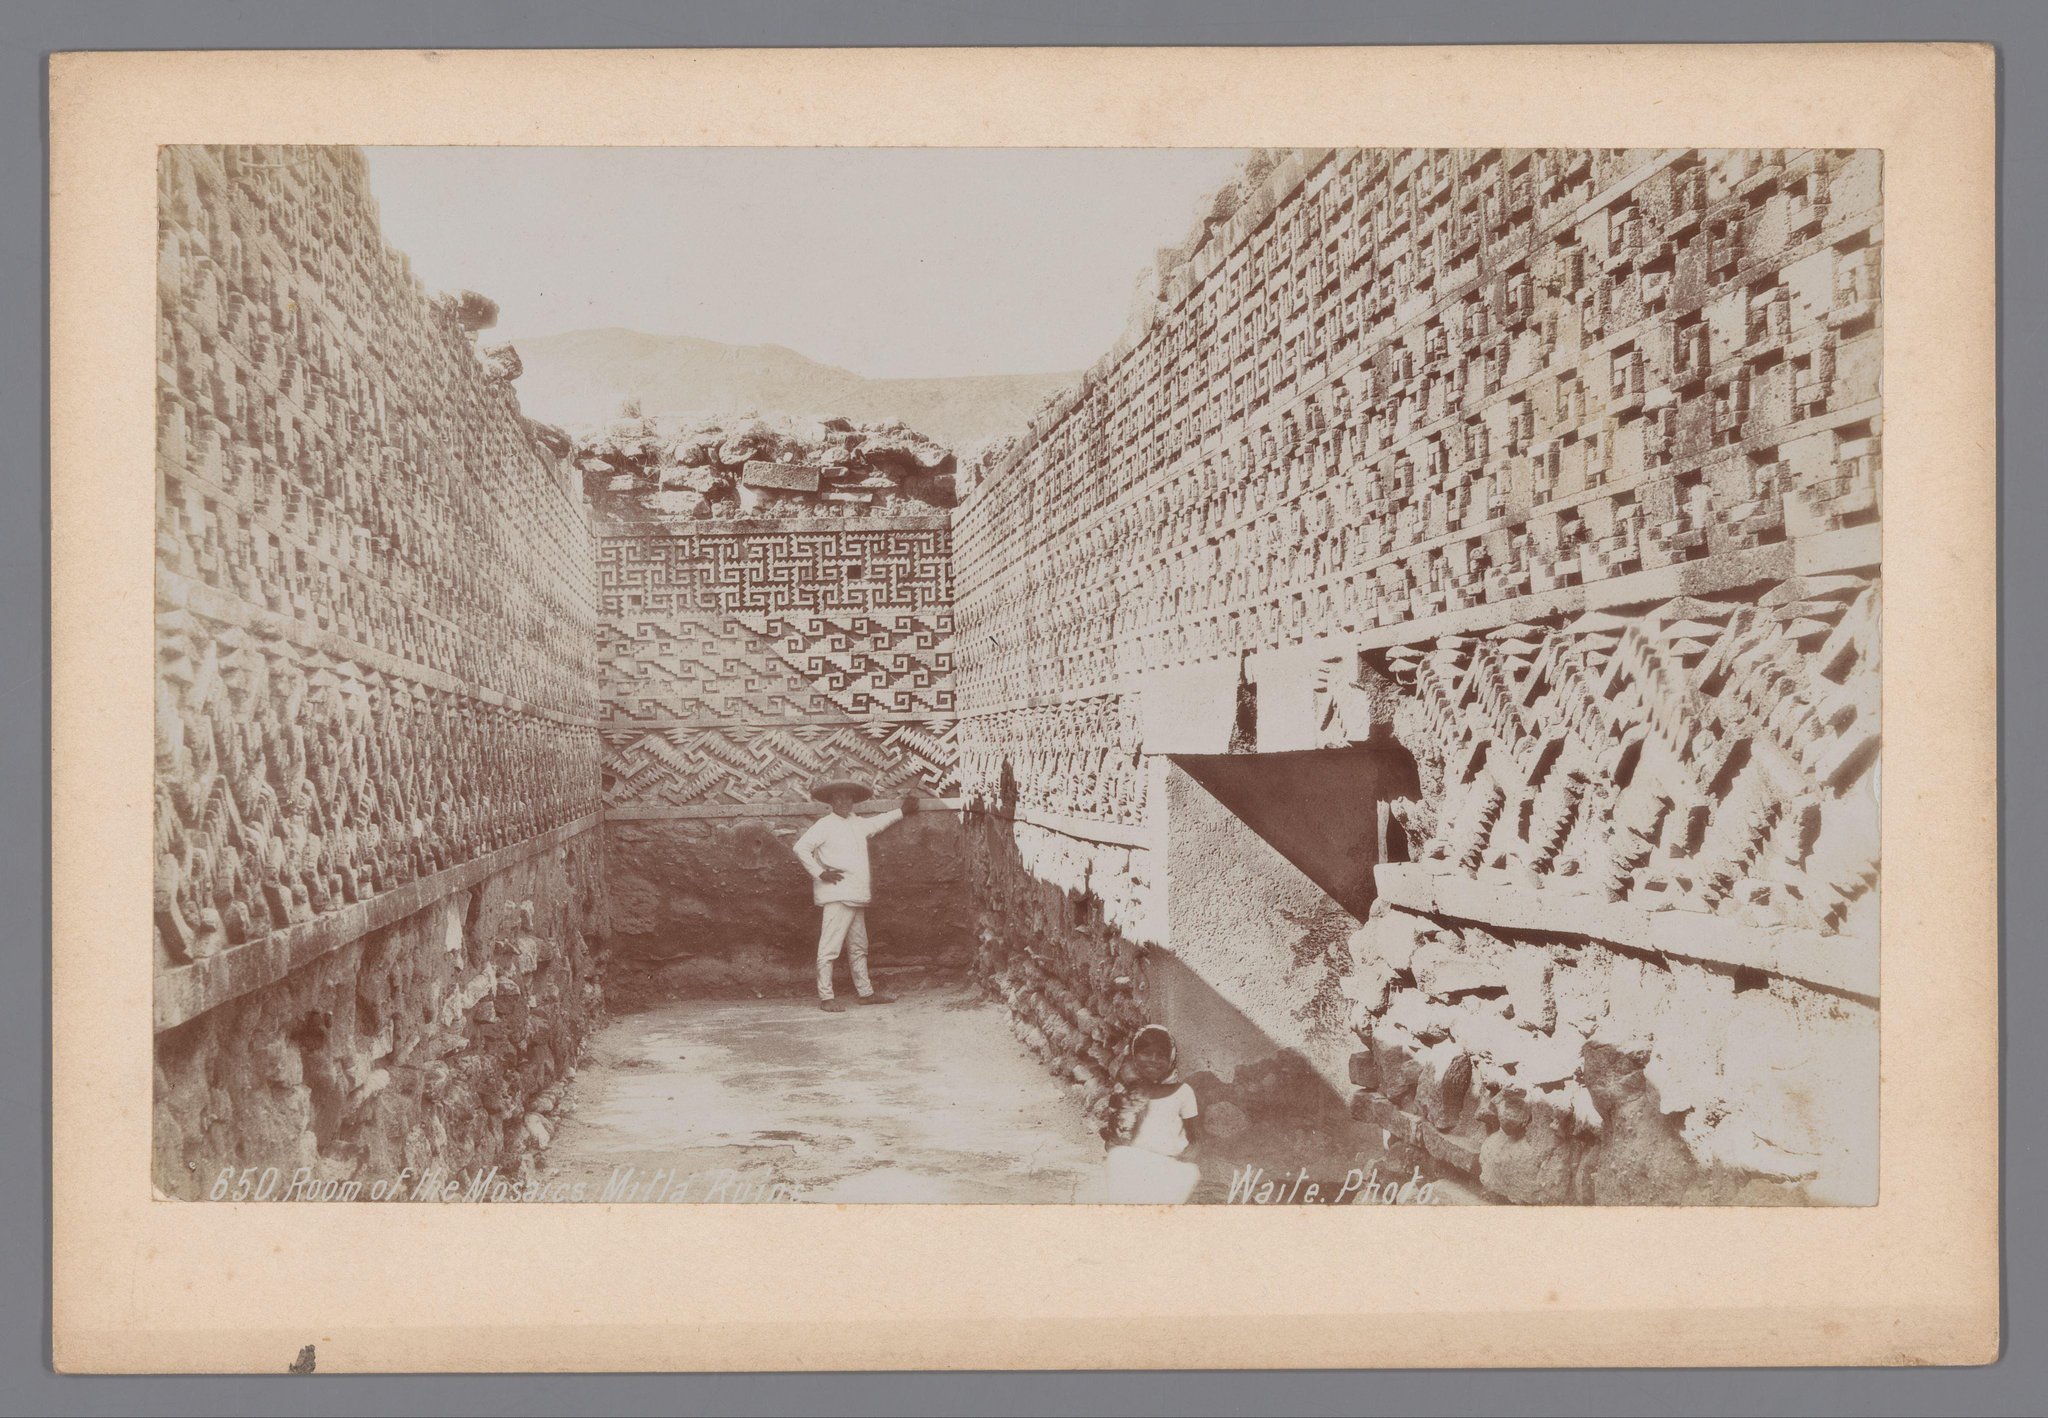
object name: photograph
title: Mexicaanse man bij de ruïnes van Mitla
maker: charles betts waite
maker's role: fotograaf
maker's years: 1861-1927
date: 1897-1923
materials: paper, cardboard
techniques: gelatin silver print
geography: oaxaca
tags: ruin of a building ~ architecture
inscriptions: number: ‘650.’